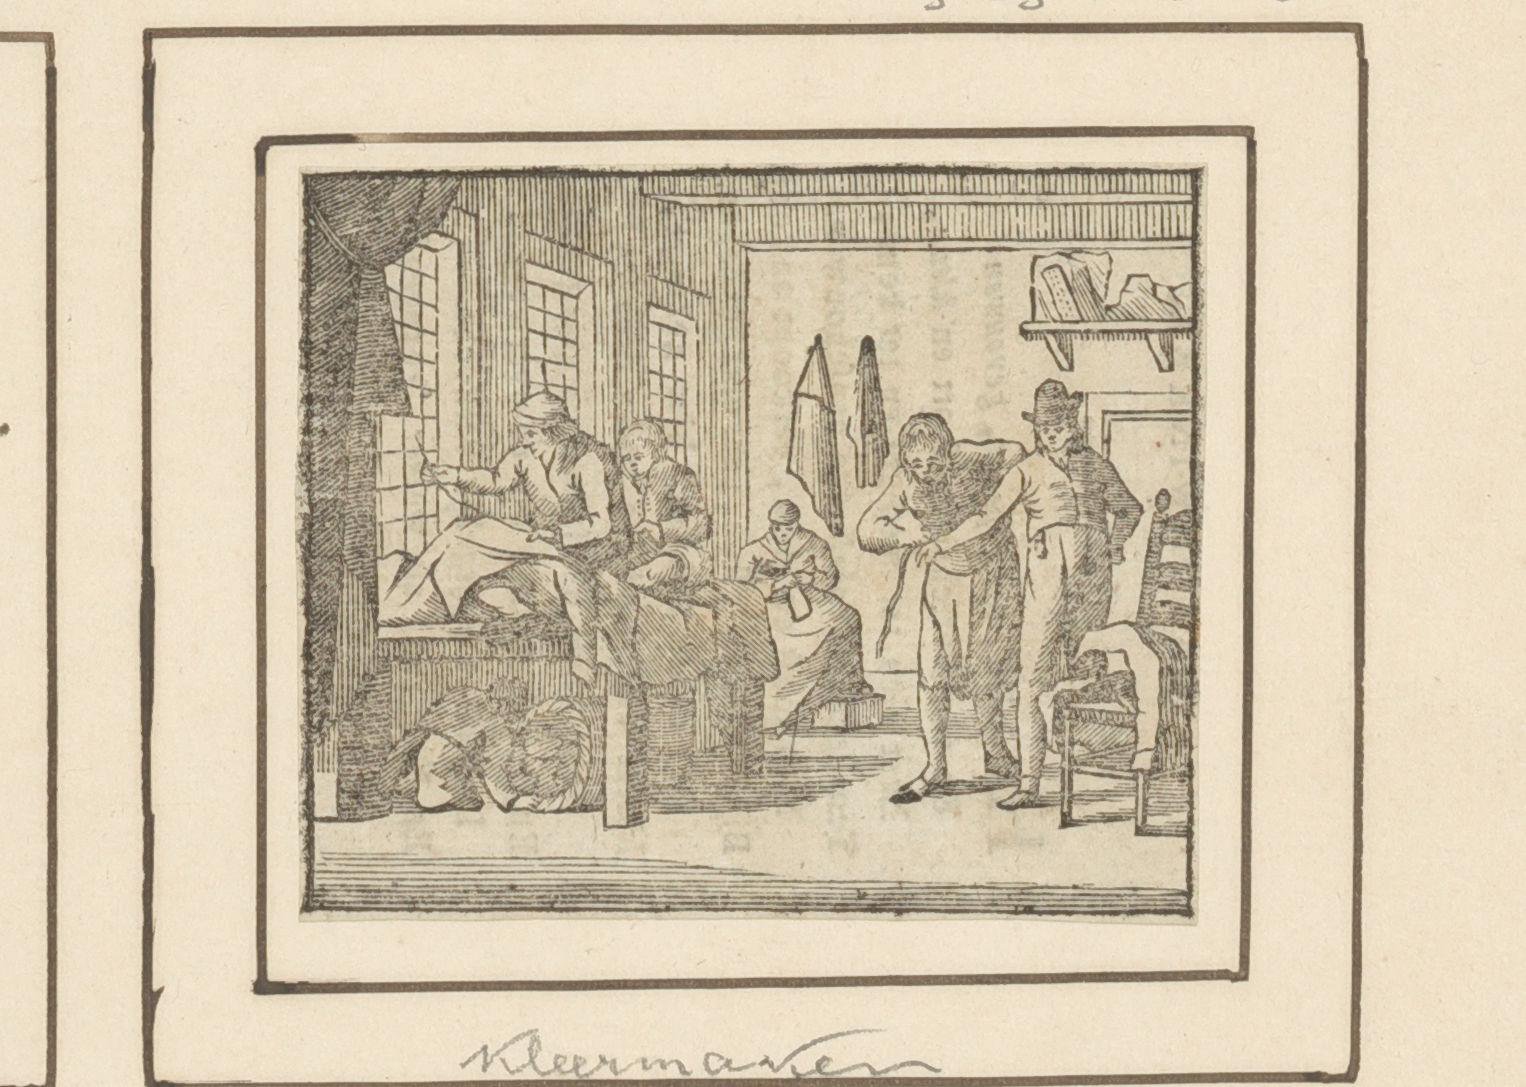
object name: print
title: Kleermakers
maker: Anonymous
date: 1815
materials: paper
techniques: letterpress printing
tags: special processes for woollen fabric, wool (material ~ textile industry)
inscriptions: stamp, collector's mark: Lugt 1641, stamp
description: Onderwerpsrubrieken binnen de Atlas Zeden en Gewoonten: Handel, Nijverheid en verkeer, Beroep en bedrijf, Mannelijk, Lakenindustrie en aanverwante vakken.